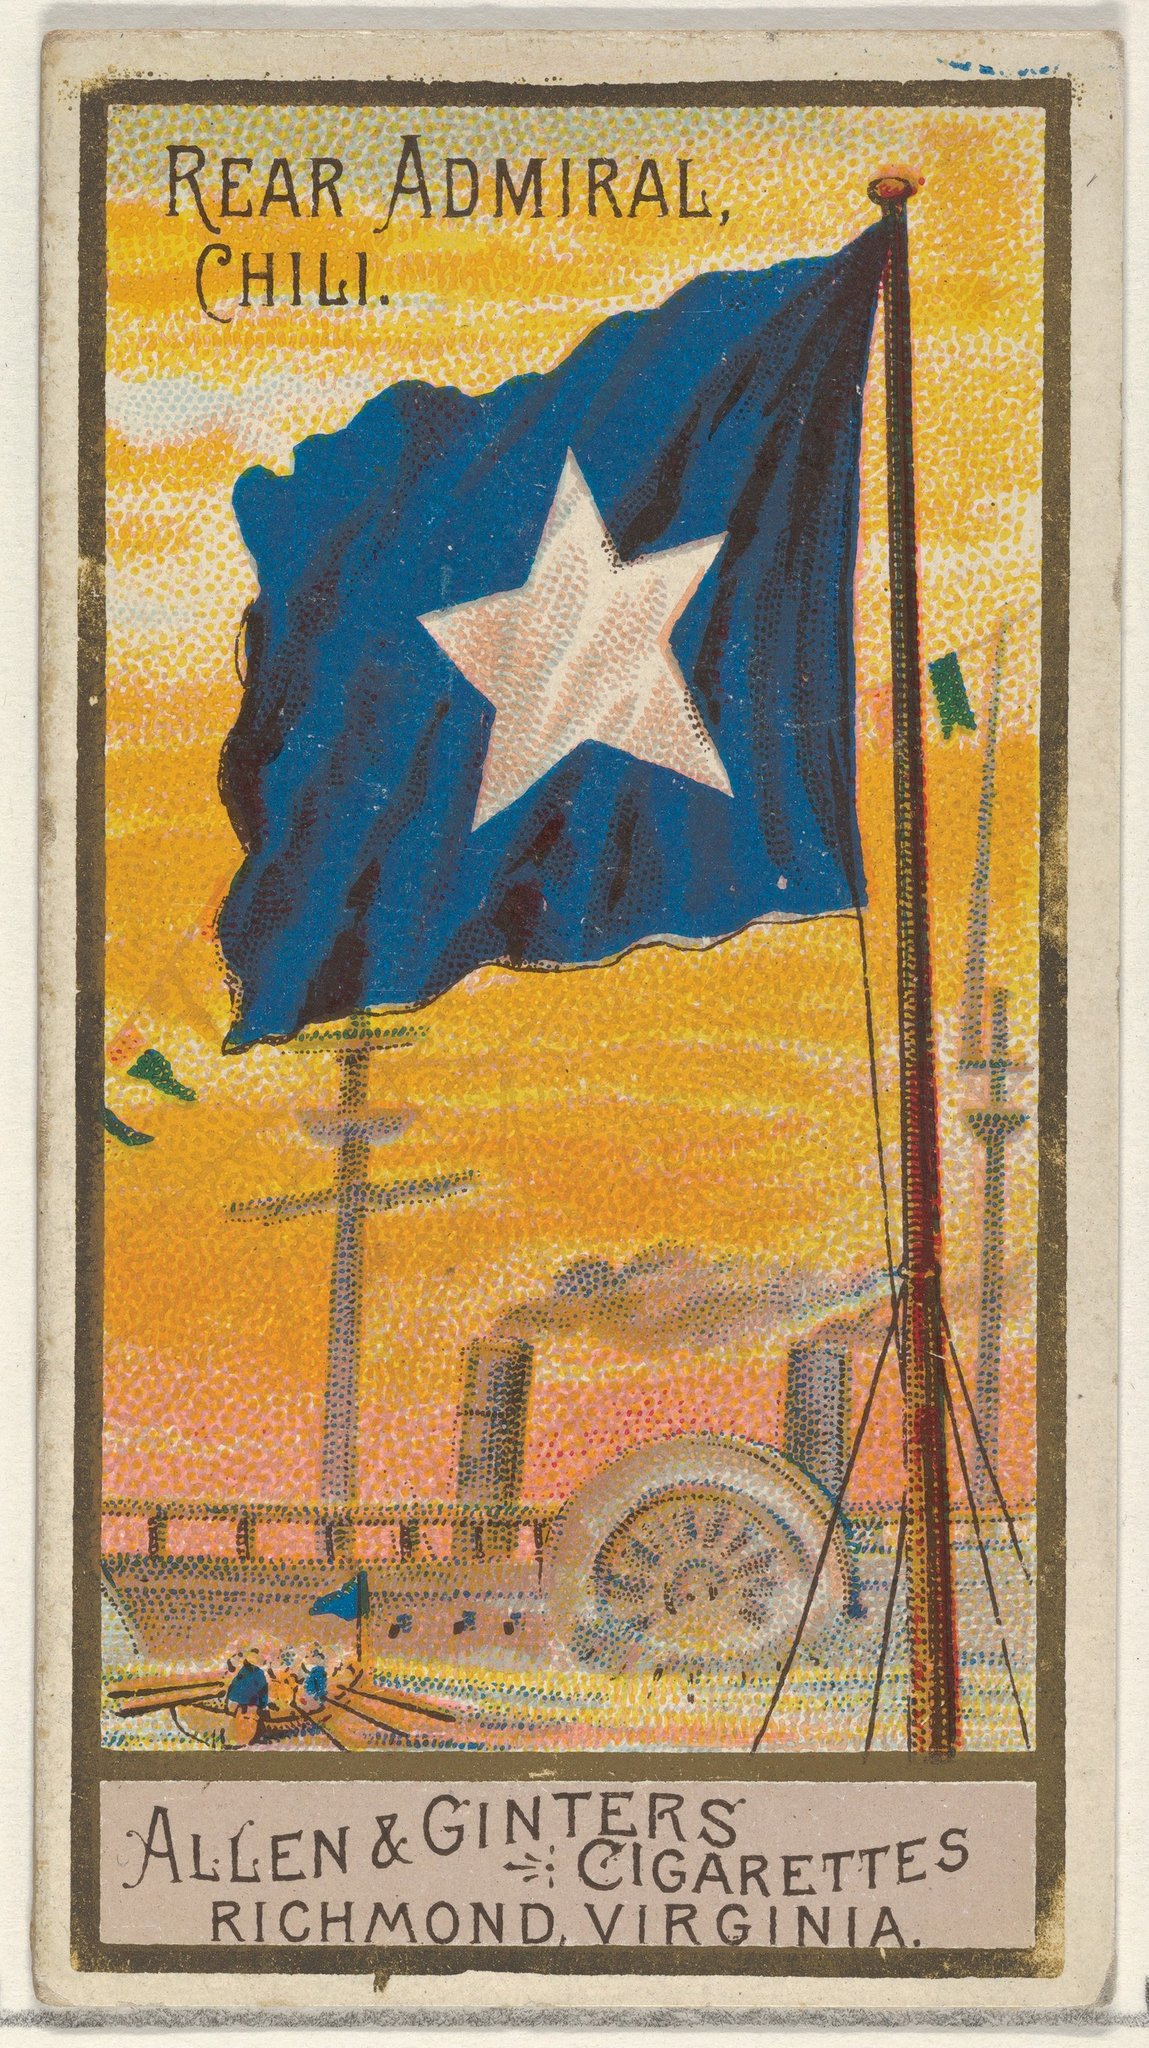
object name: print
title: Rear Admiral, Chili, from the Naval Flags series (N17) for Allen & Ginter Cigarettes Brands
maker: allen & ginter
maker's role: publisher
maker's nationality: american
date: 1888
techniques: color lithograph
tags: flags